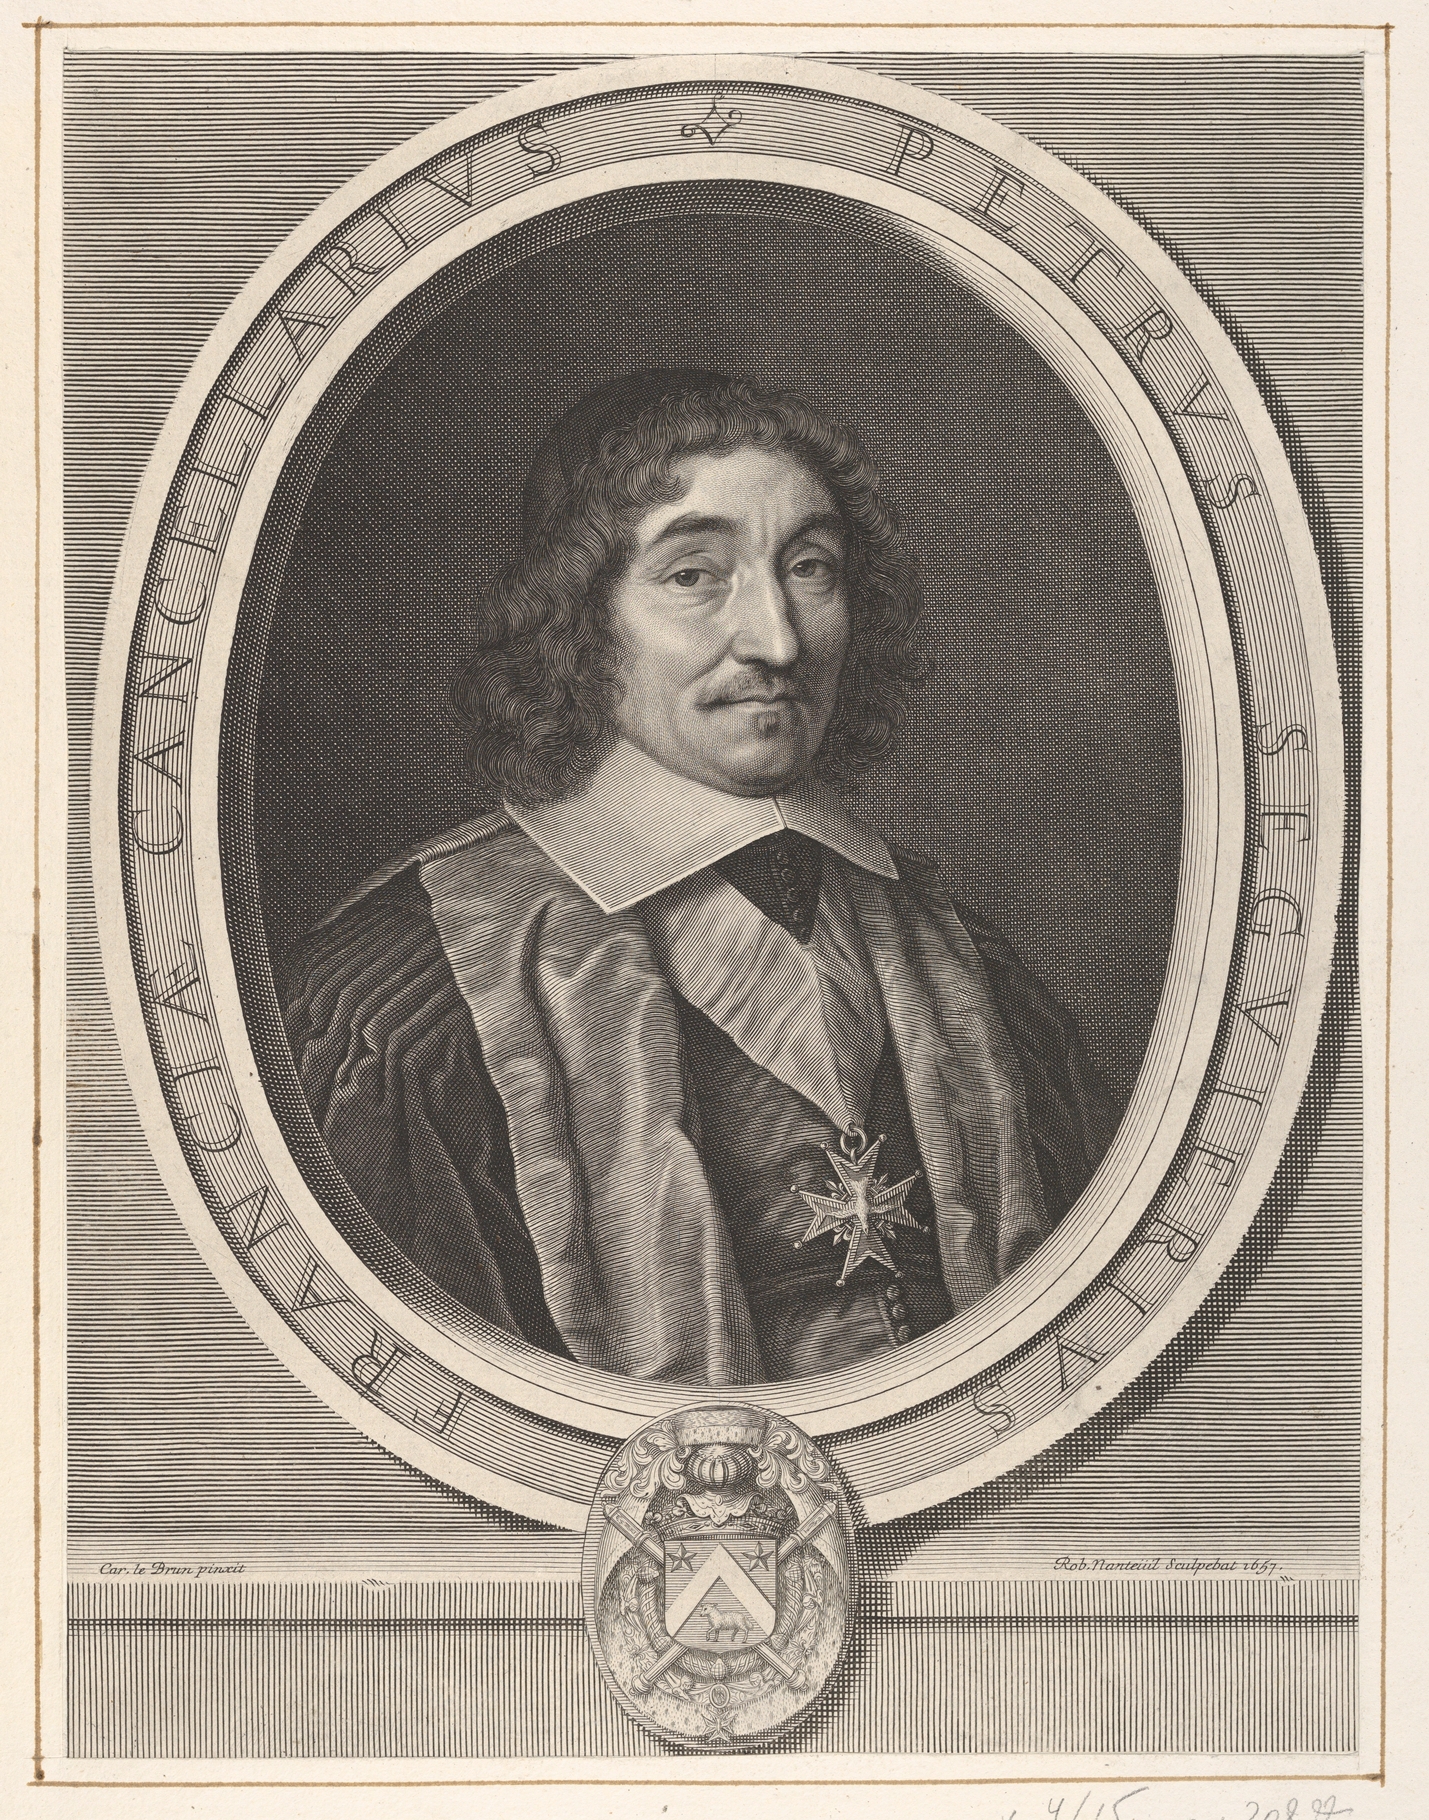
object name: print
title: Le chancelier Pierre Séguier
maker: robert nanteuil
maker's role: artist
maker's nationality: french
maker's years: 1623-1678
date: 1657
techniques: engraving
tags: men,portraits,coat of arms